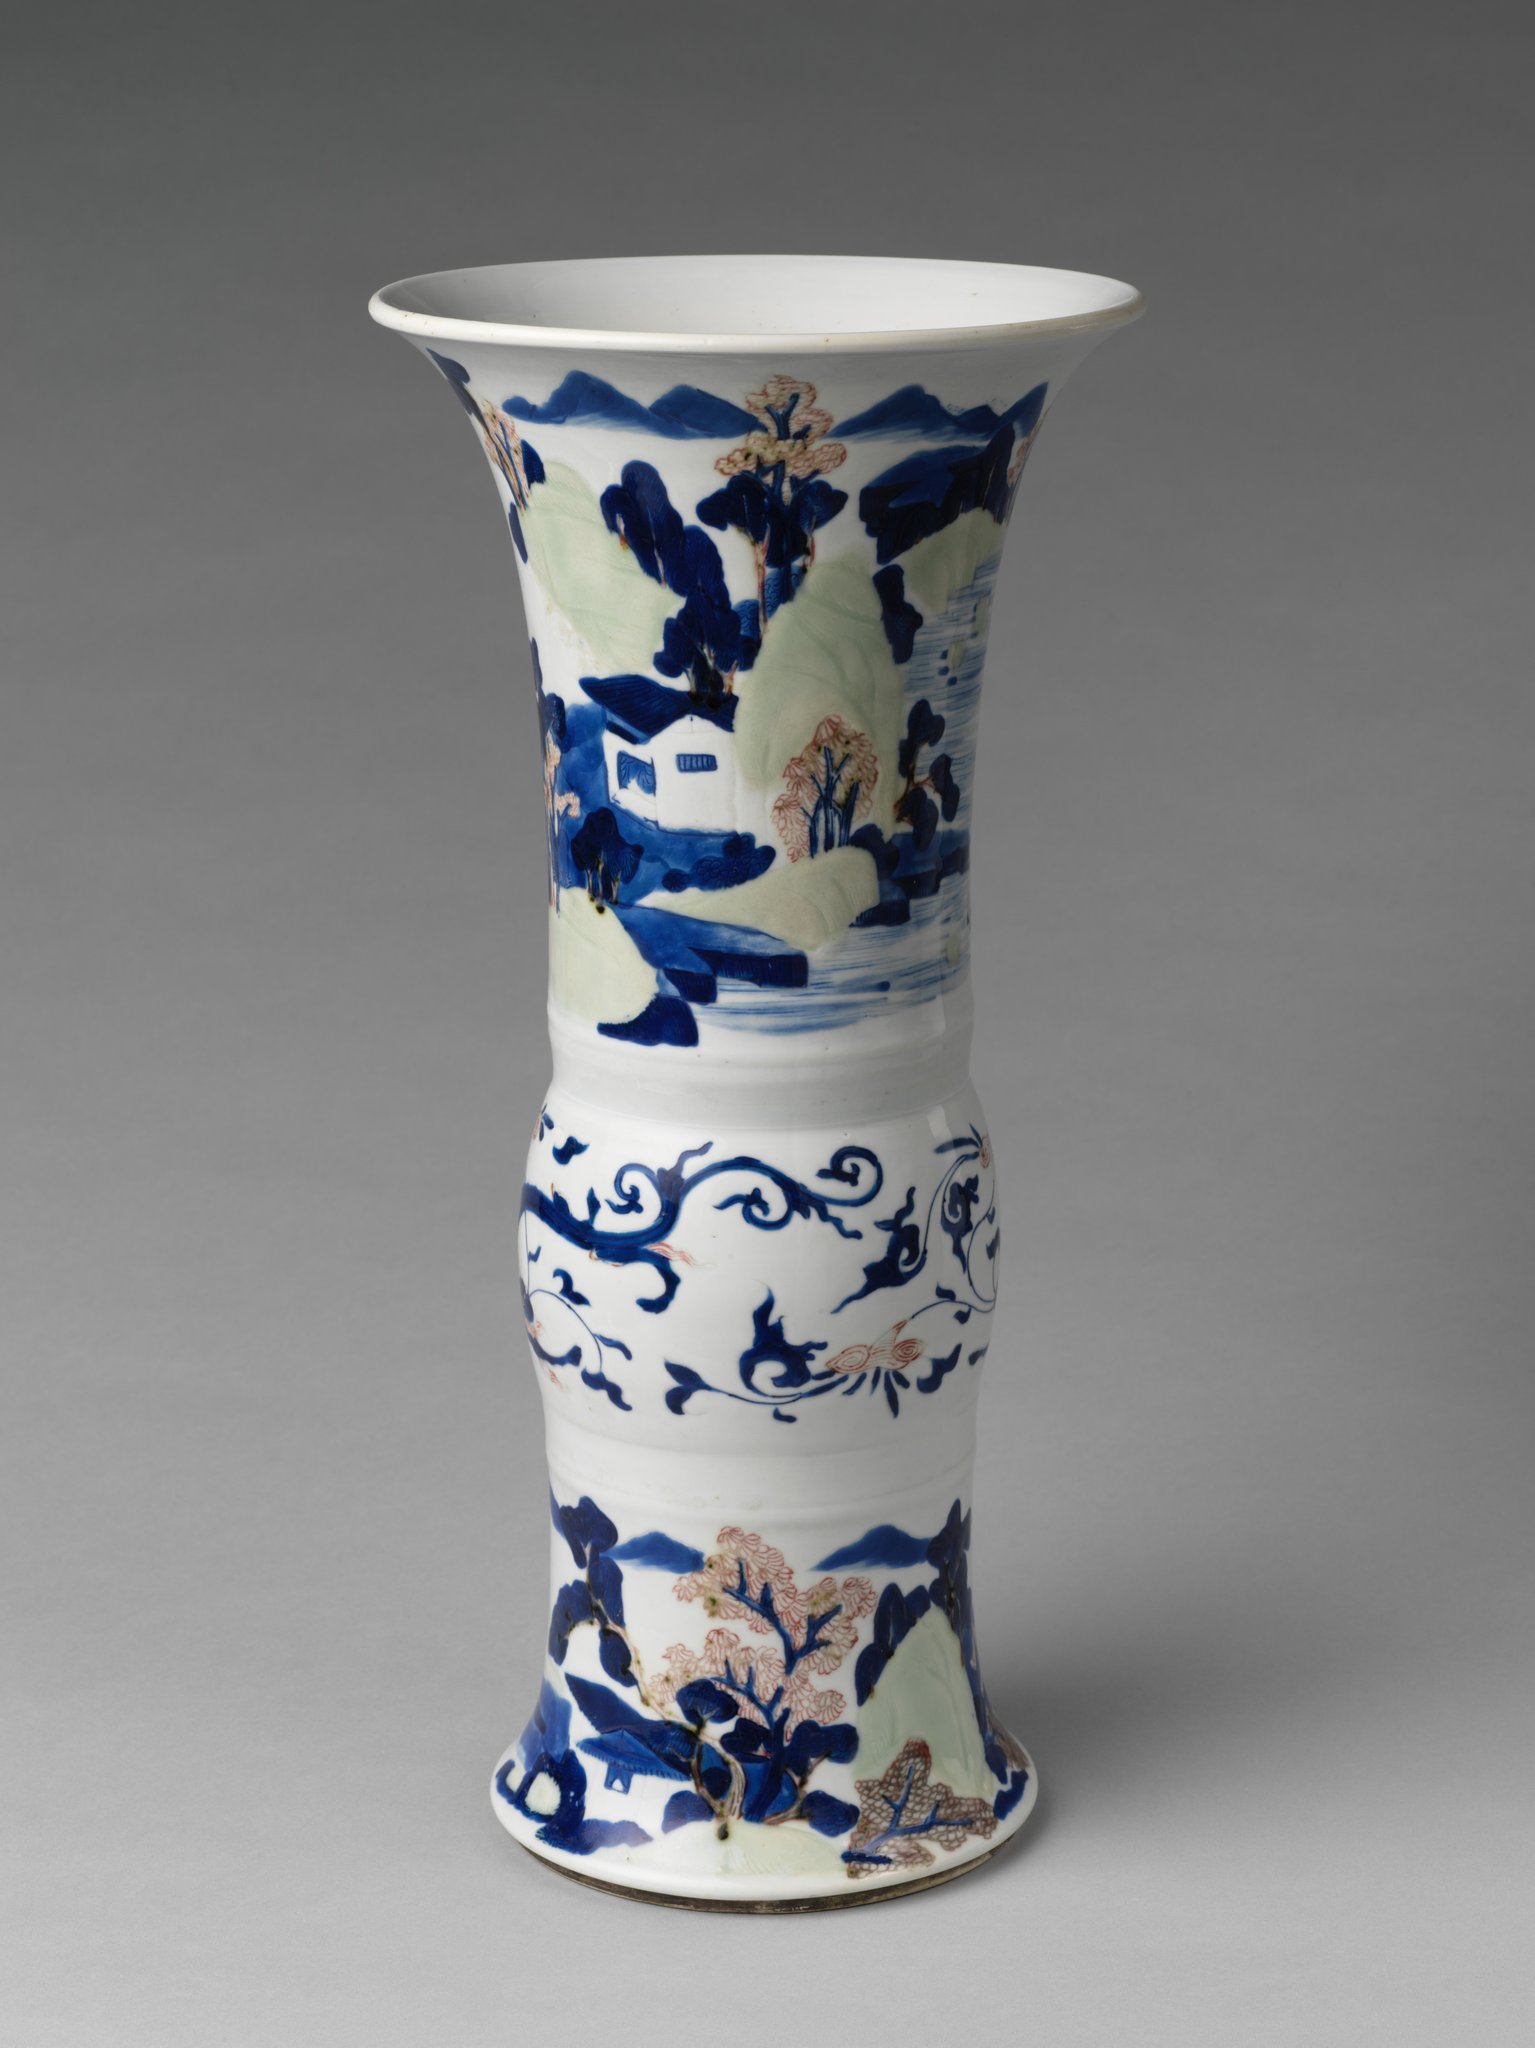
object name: vase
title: Vase with landscape scenes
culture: chinese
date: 1667-1700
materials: cobalt, copper, porcelain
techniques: painting, underglaze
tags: landscapes